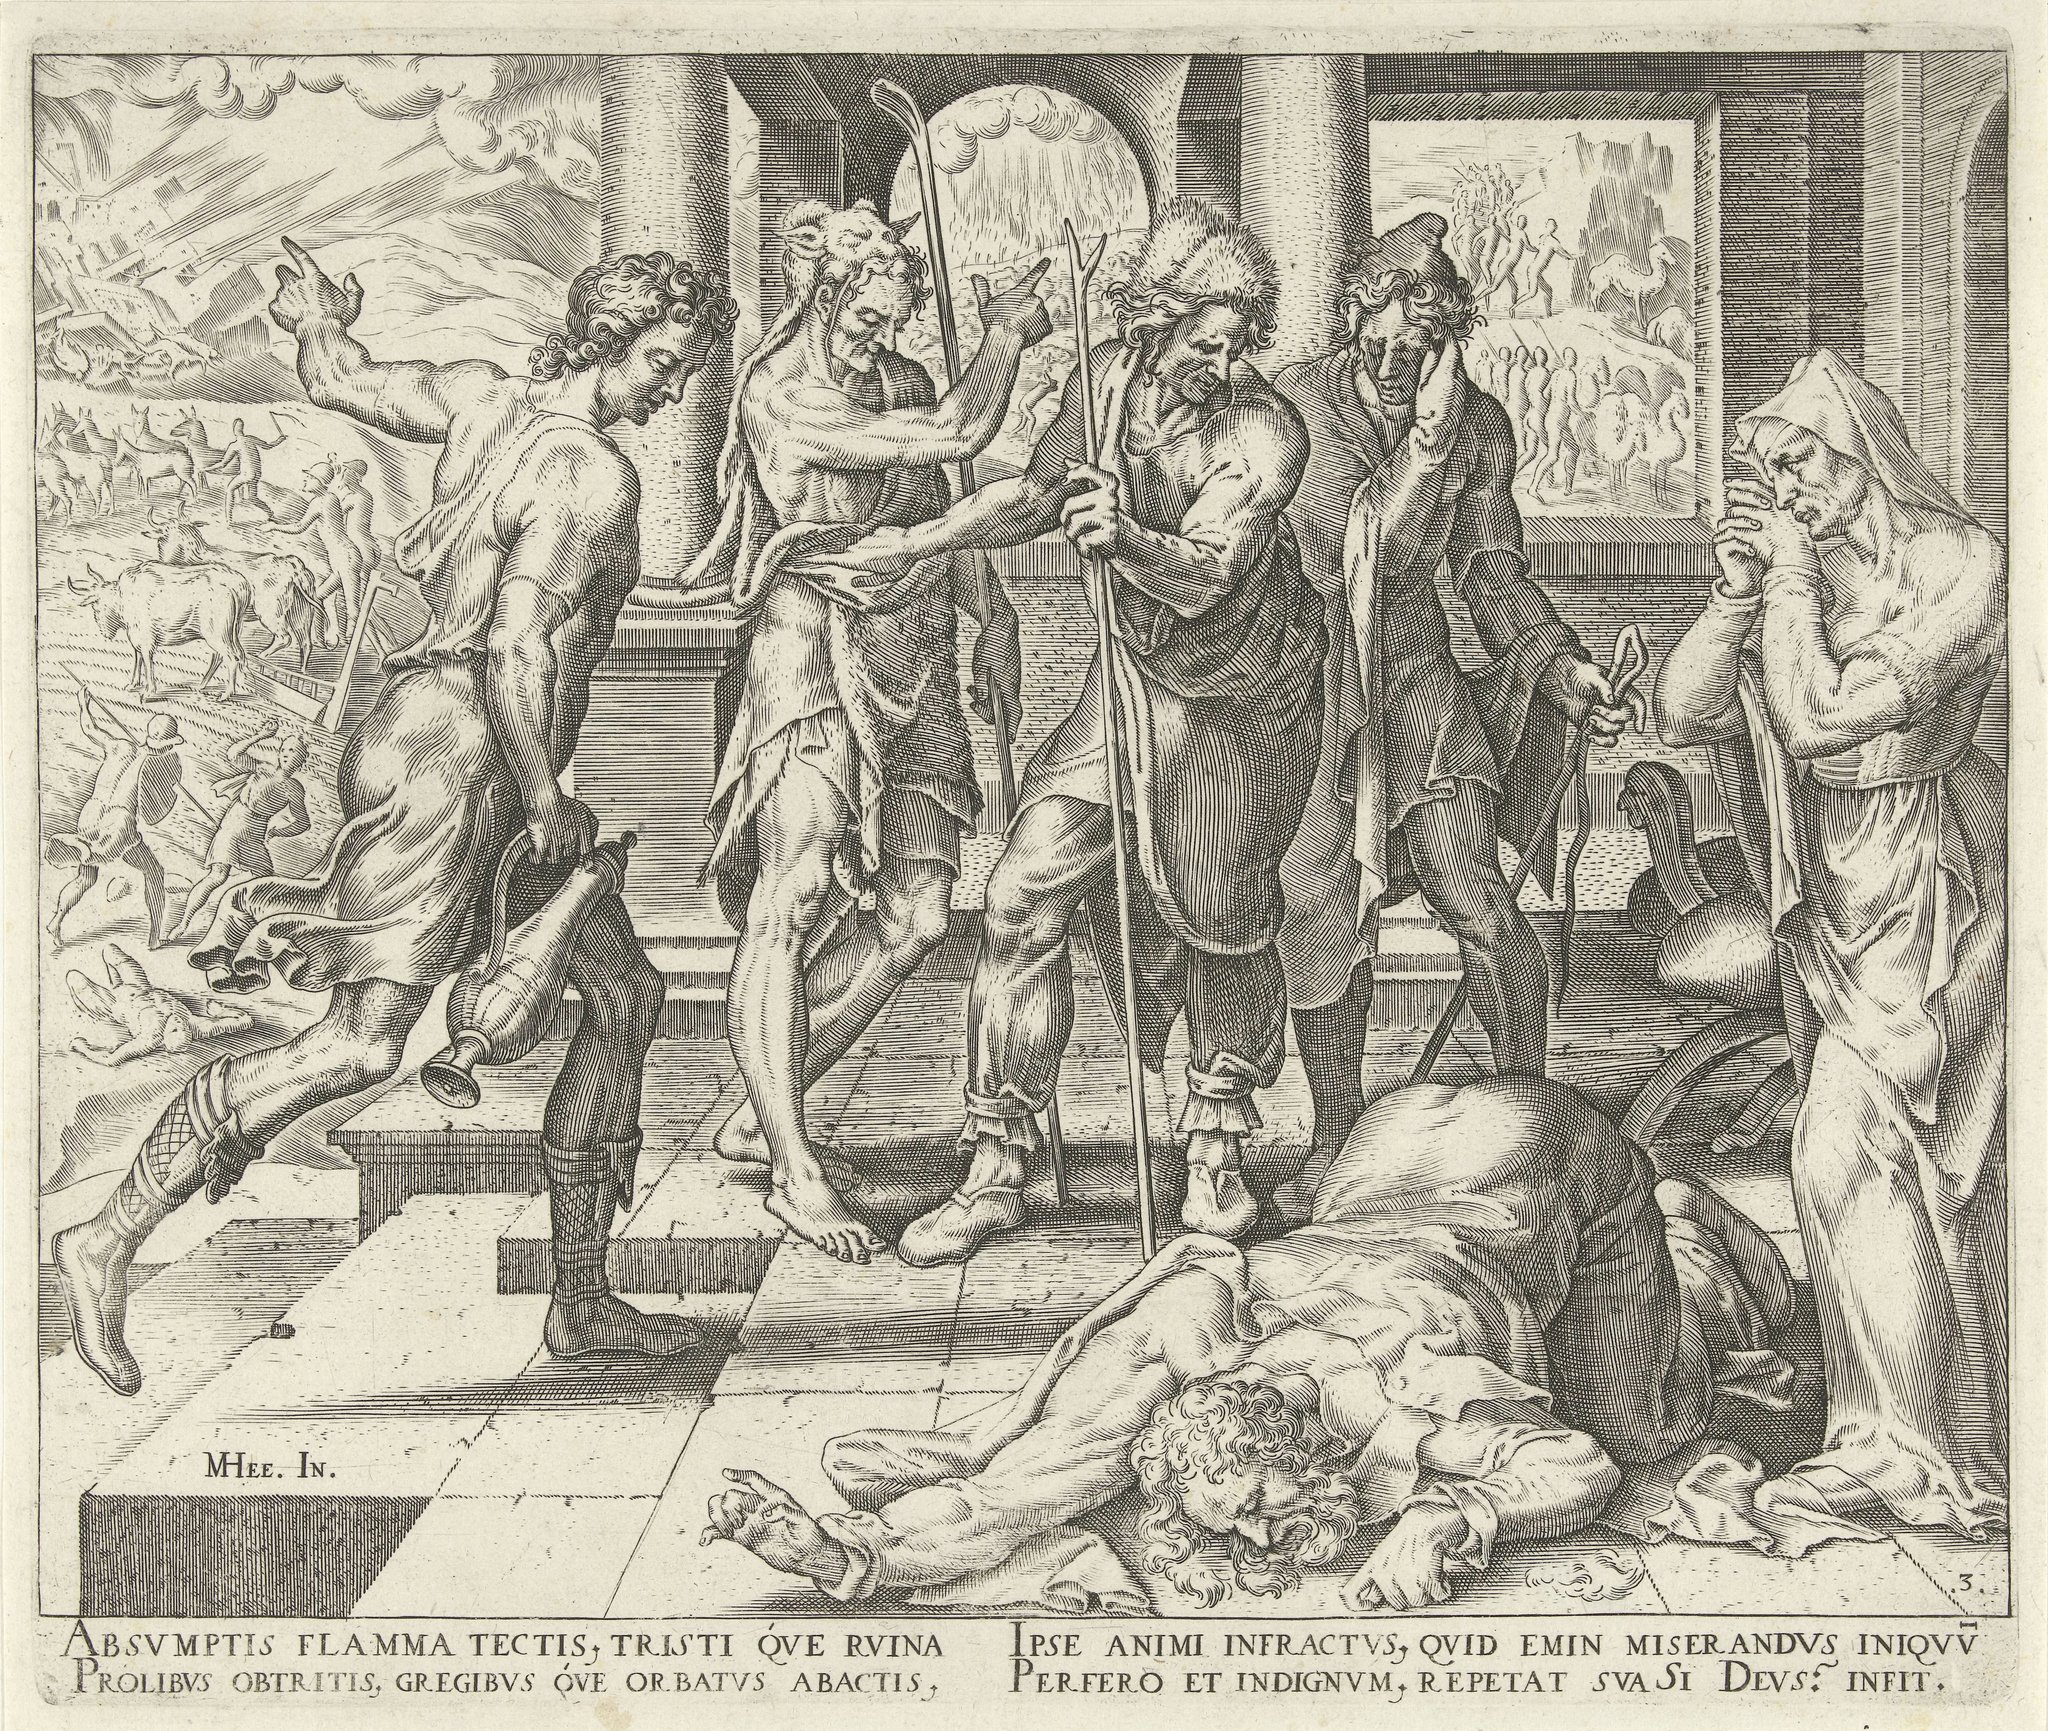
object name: print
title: Geschiedenis van Job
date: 1563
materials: paper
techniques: engraving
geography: haarlem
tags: job falls upon the ground and expresses his resignation to god's will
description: Vier boodschappers komen bij Job om hem te vertellen dat zijn kuddes zijn geroofd en door de bliksem getroffen en dat zijn huis is ingestort en zijn kinderen onder het puin bedolven zijn. Nadat Job het slechte nieuws heeft gehoord van de boodschappers verscheurt hij zijn kleren en valt hij neer op de grond.